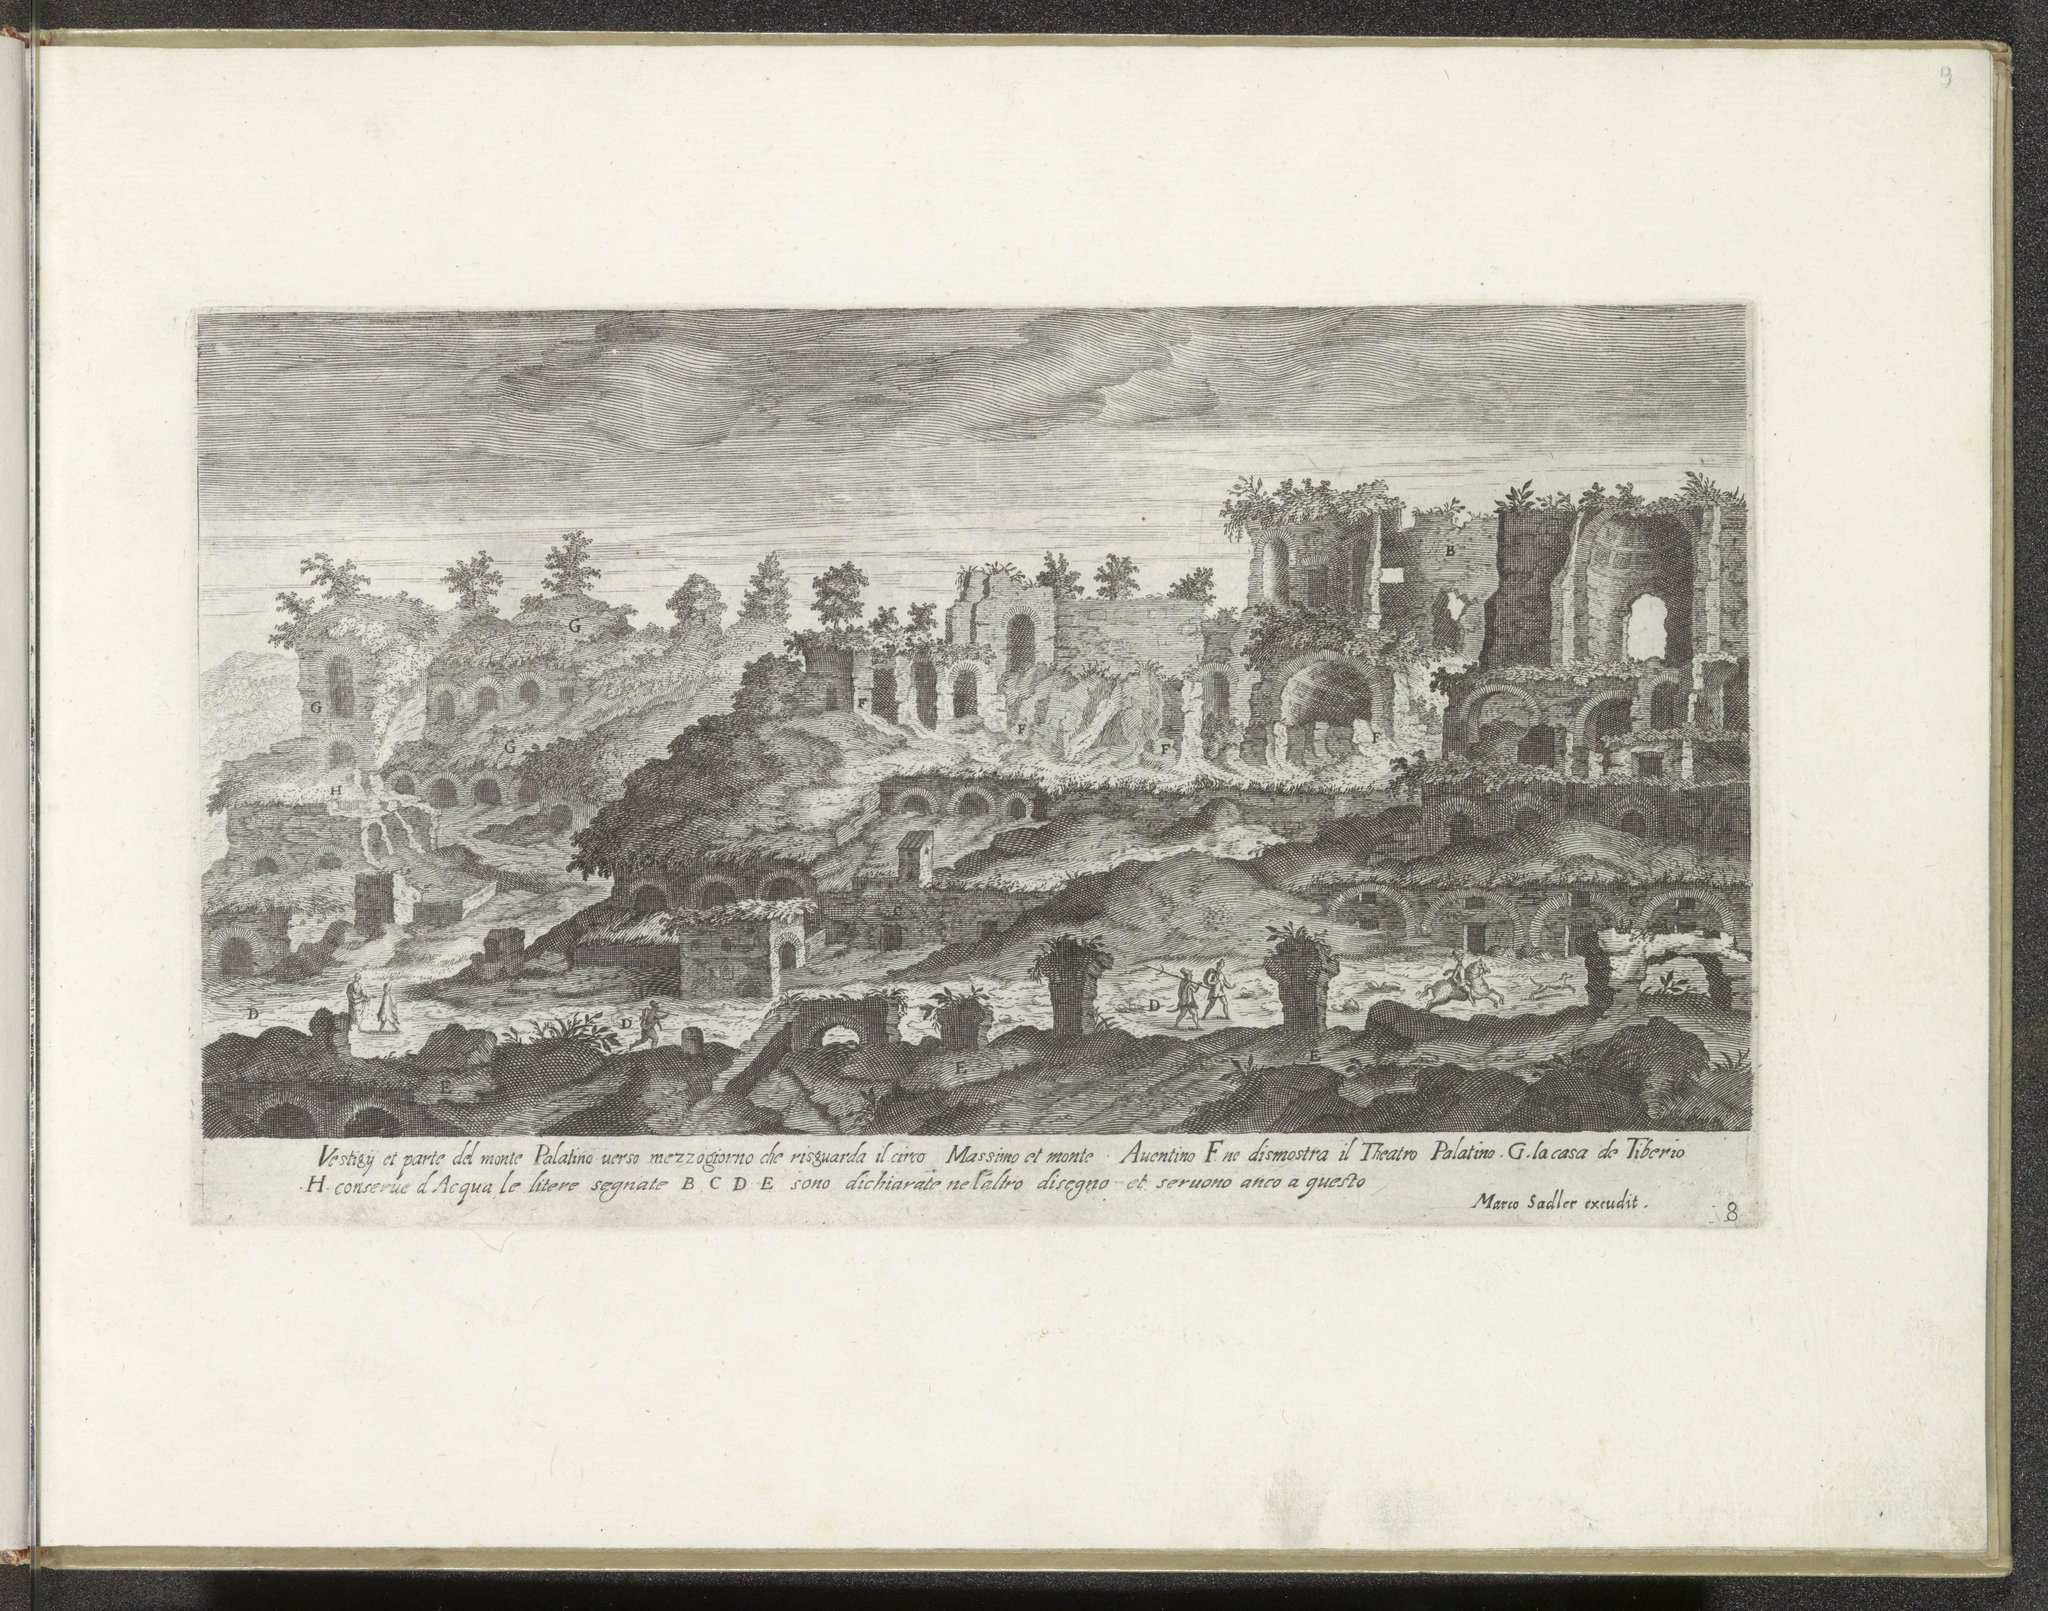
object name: album leaf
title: Ruïnes op de hellingen van de Palatijn, links de Casa di Tiberio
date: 1606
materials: paper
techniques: engraving, etching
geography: prague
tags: palatijn, casa di tiberio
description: Ruïnes op de hellingen van de Palatijn. Links de Casa di Tiberio. Figuren op de voorgrond. Rechts een man op een paard en een hond. In de ondermarge twee regels tekst in het Italiaans. De prent maakt deel uit van een album.